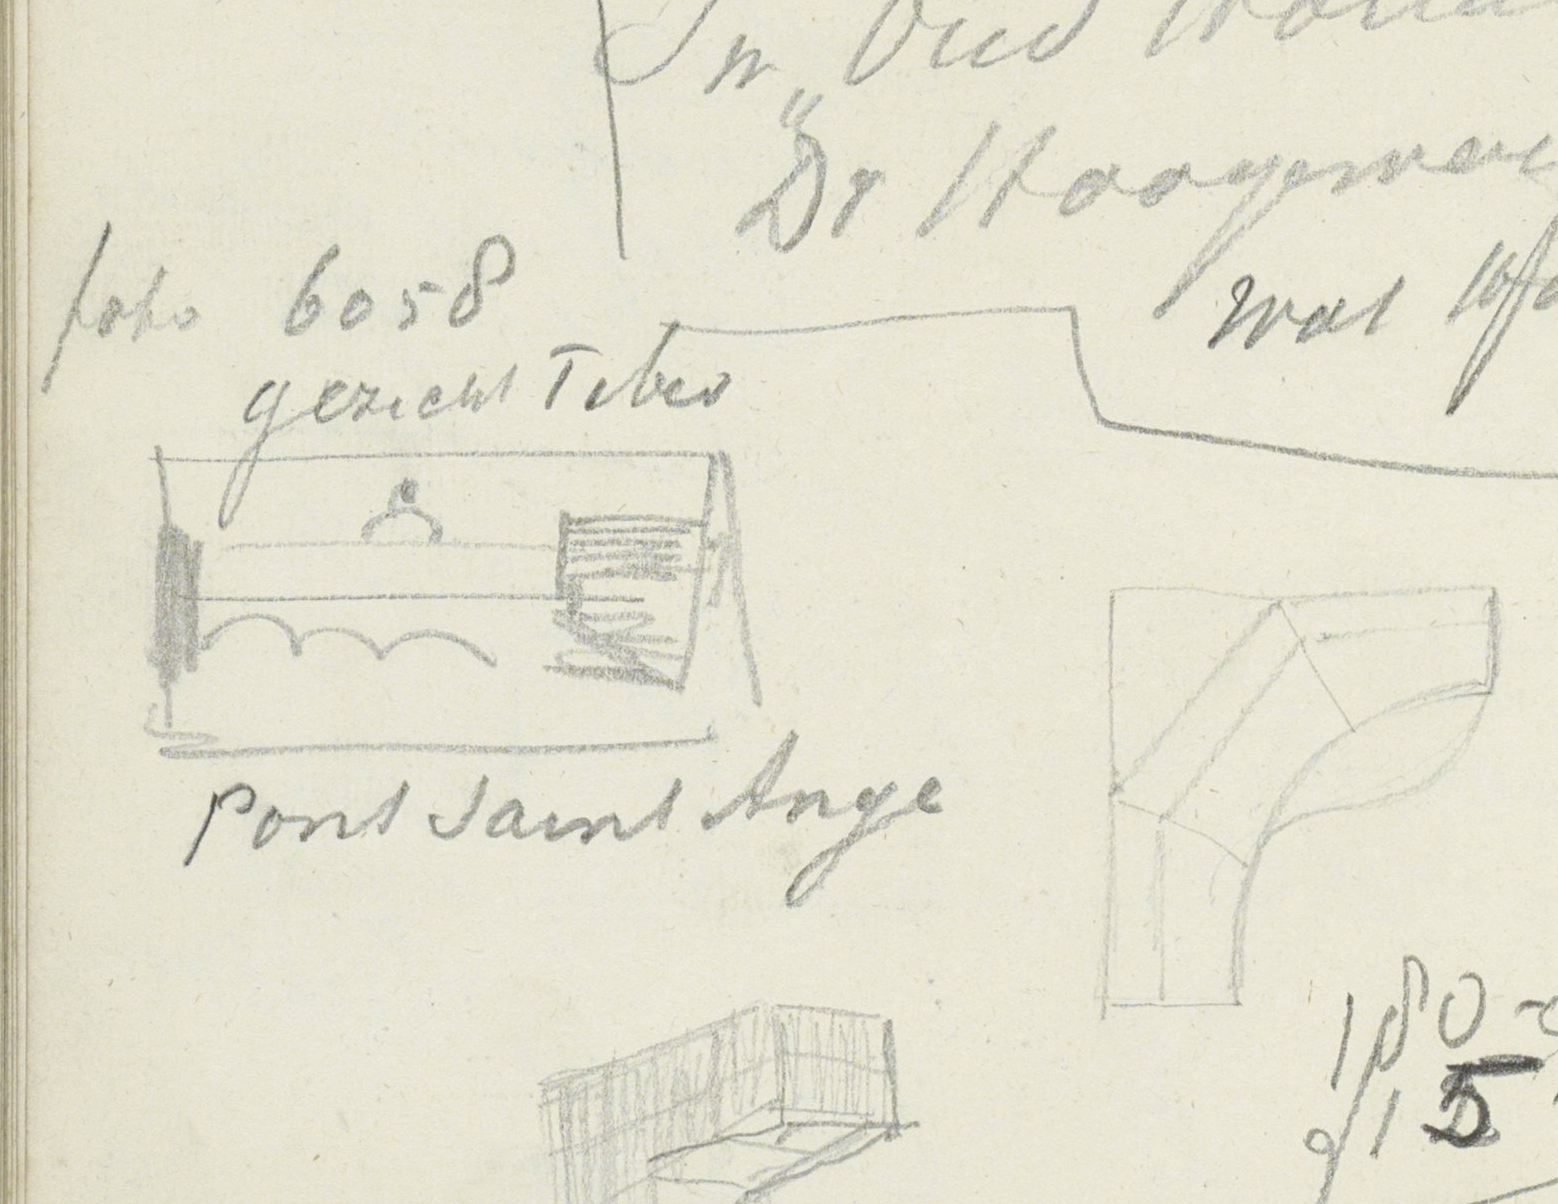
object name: sketchbook leaf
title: Kopie naar een foto en ontwerpen voor wanddecoraties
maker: carel adolph lion cachet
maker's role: draughtsman, print maker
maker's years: 1864-1945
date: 1928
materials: paper, pencil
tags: architectural detail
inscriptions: annotation: ‘foto no 28672/ foto 6058/ gezicht Tiber/ Pont Saint Ange/ In Oud Holland 1924/ Dr Hoogewerf/ wat [...]oof in [...]’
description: Mogelijk maken de ontwerpen deel uit van een sierlijst. Blad 16 verso uit een schetsboek met 24 bladen.